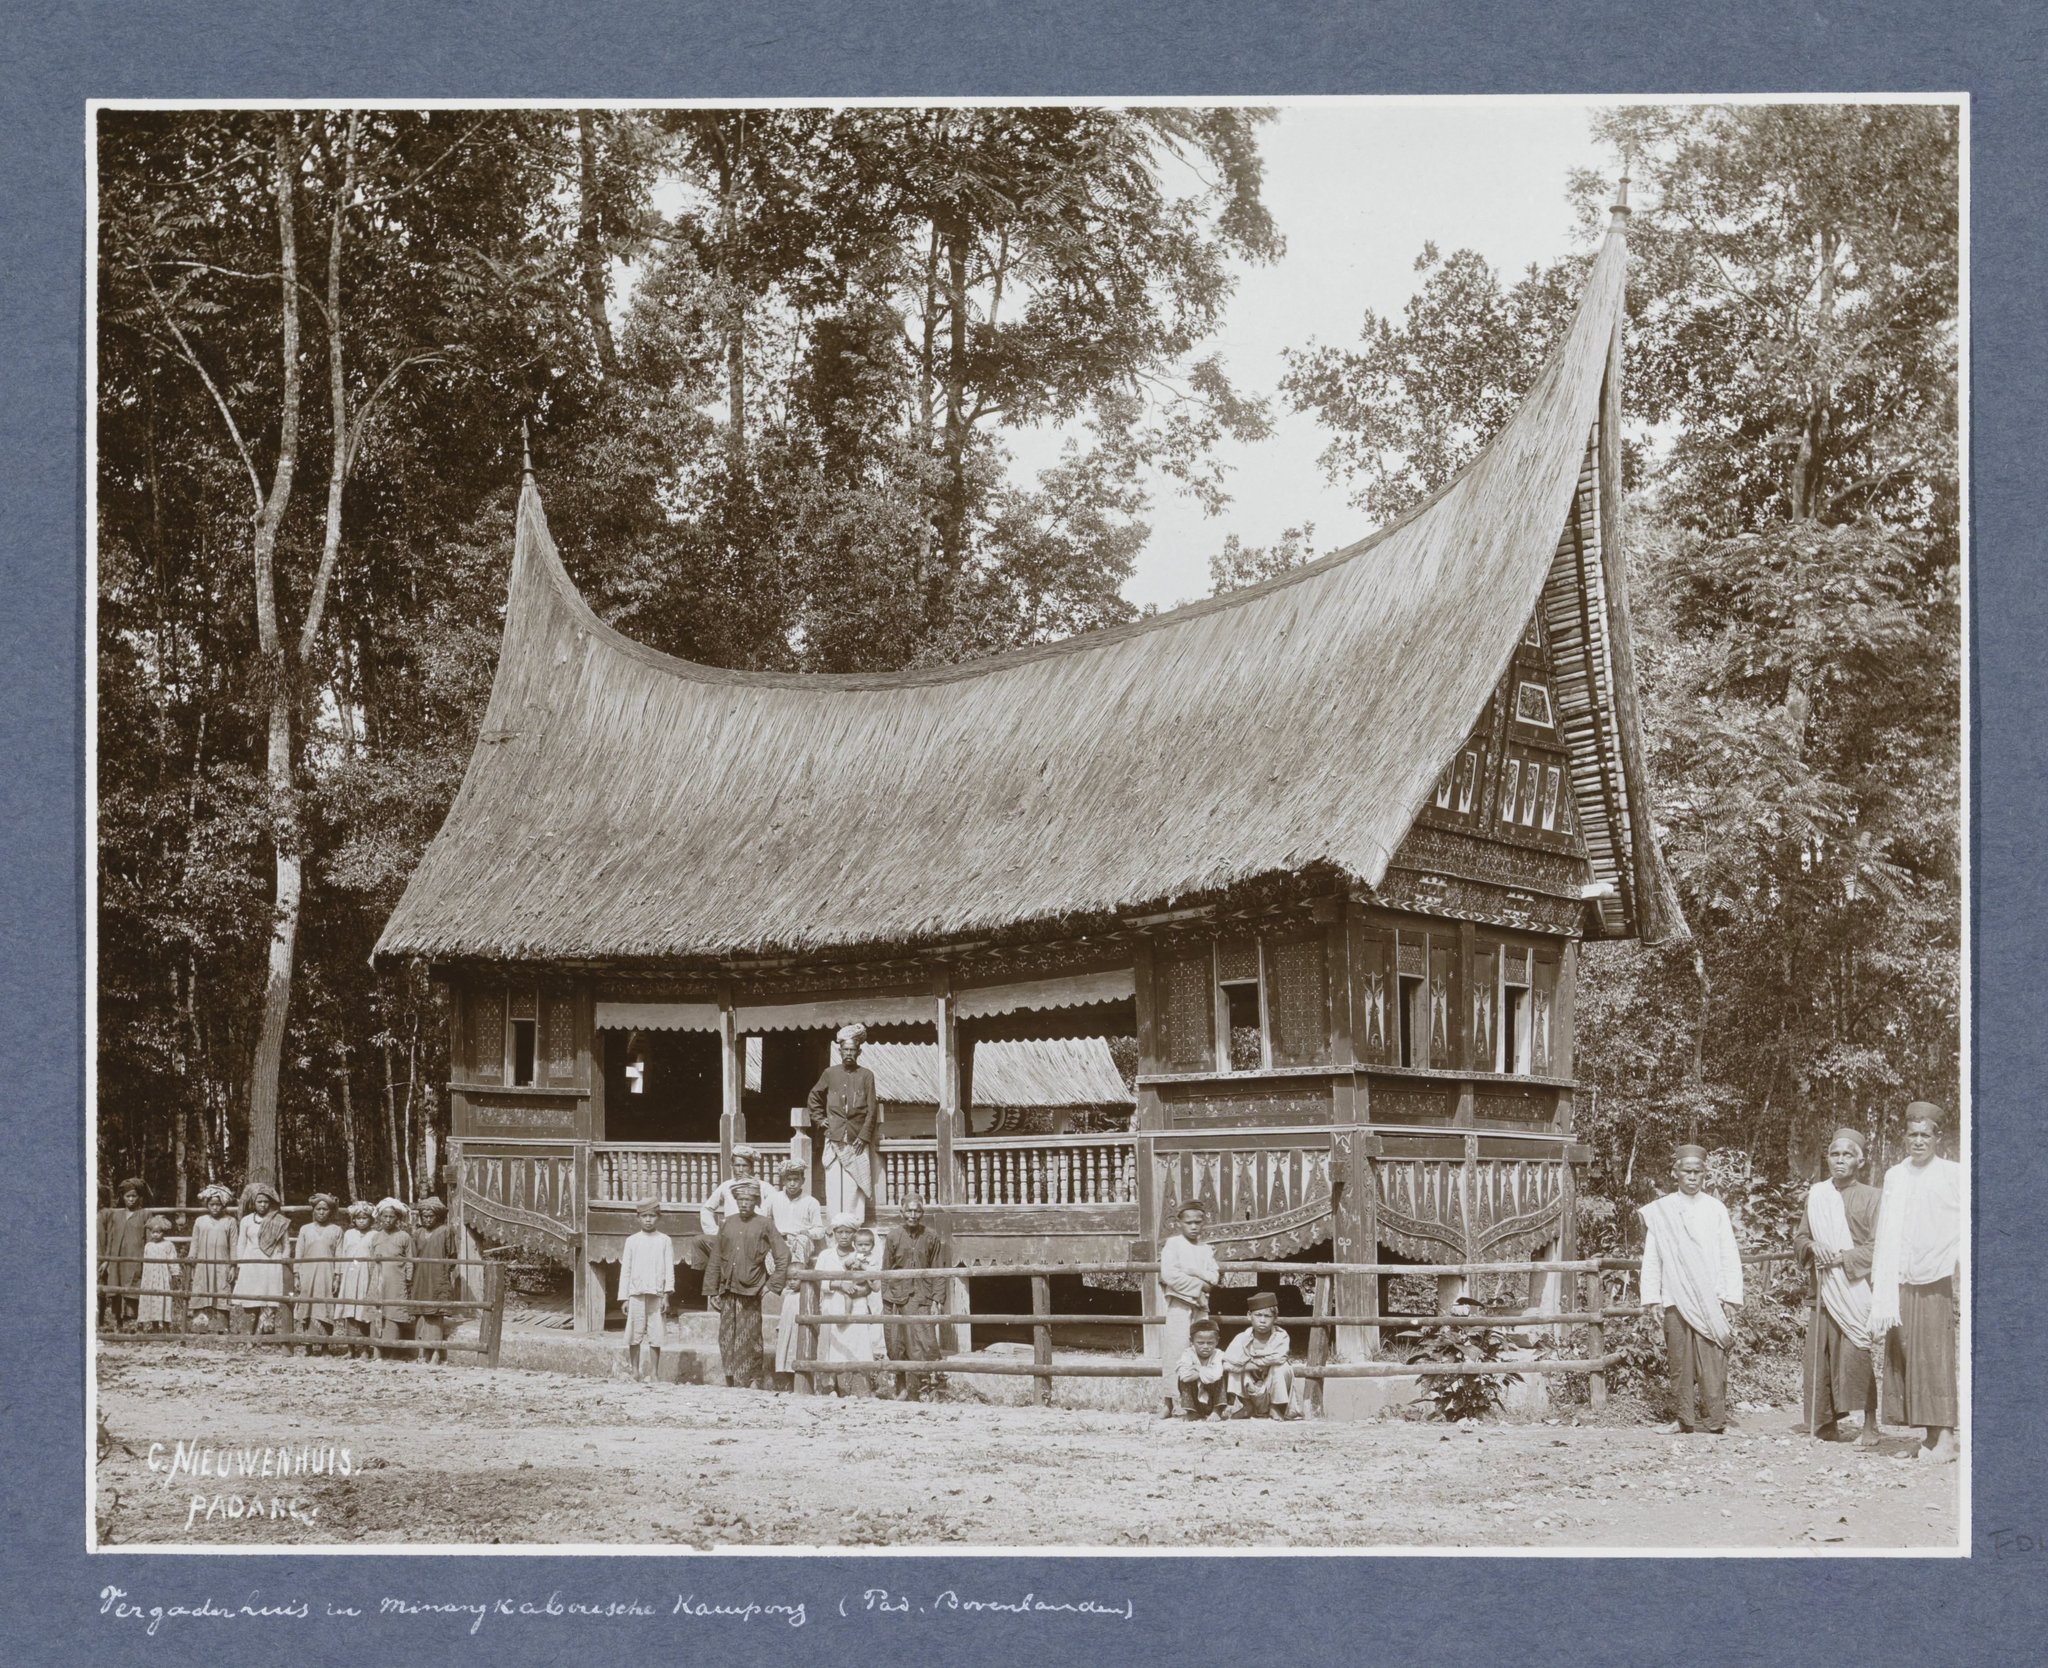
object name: album leaf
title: Mannen, vrouwen en kinderen poserend voor een vergaderhuis in Minangkabou op Sumatra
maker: christiaan benjamin nieuwenhuis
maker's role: publisher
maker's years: 1863-1922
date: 1900-1920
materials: paper, photographic support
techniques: gelatin silver print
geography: sumatra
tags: exterior ~ representation of a building, façade (of house or building), sumatra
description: Onderdeel van reisalbum met foto's van bedrijvigheid en bezienswaardigheden op Sumatra en Java en van de reis naar en van Nederlands-Indië.